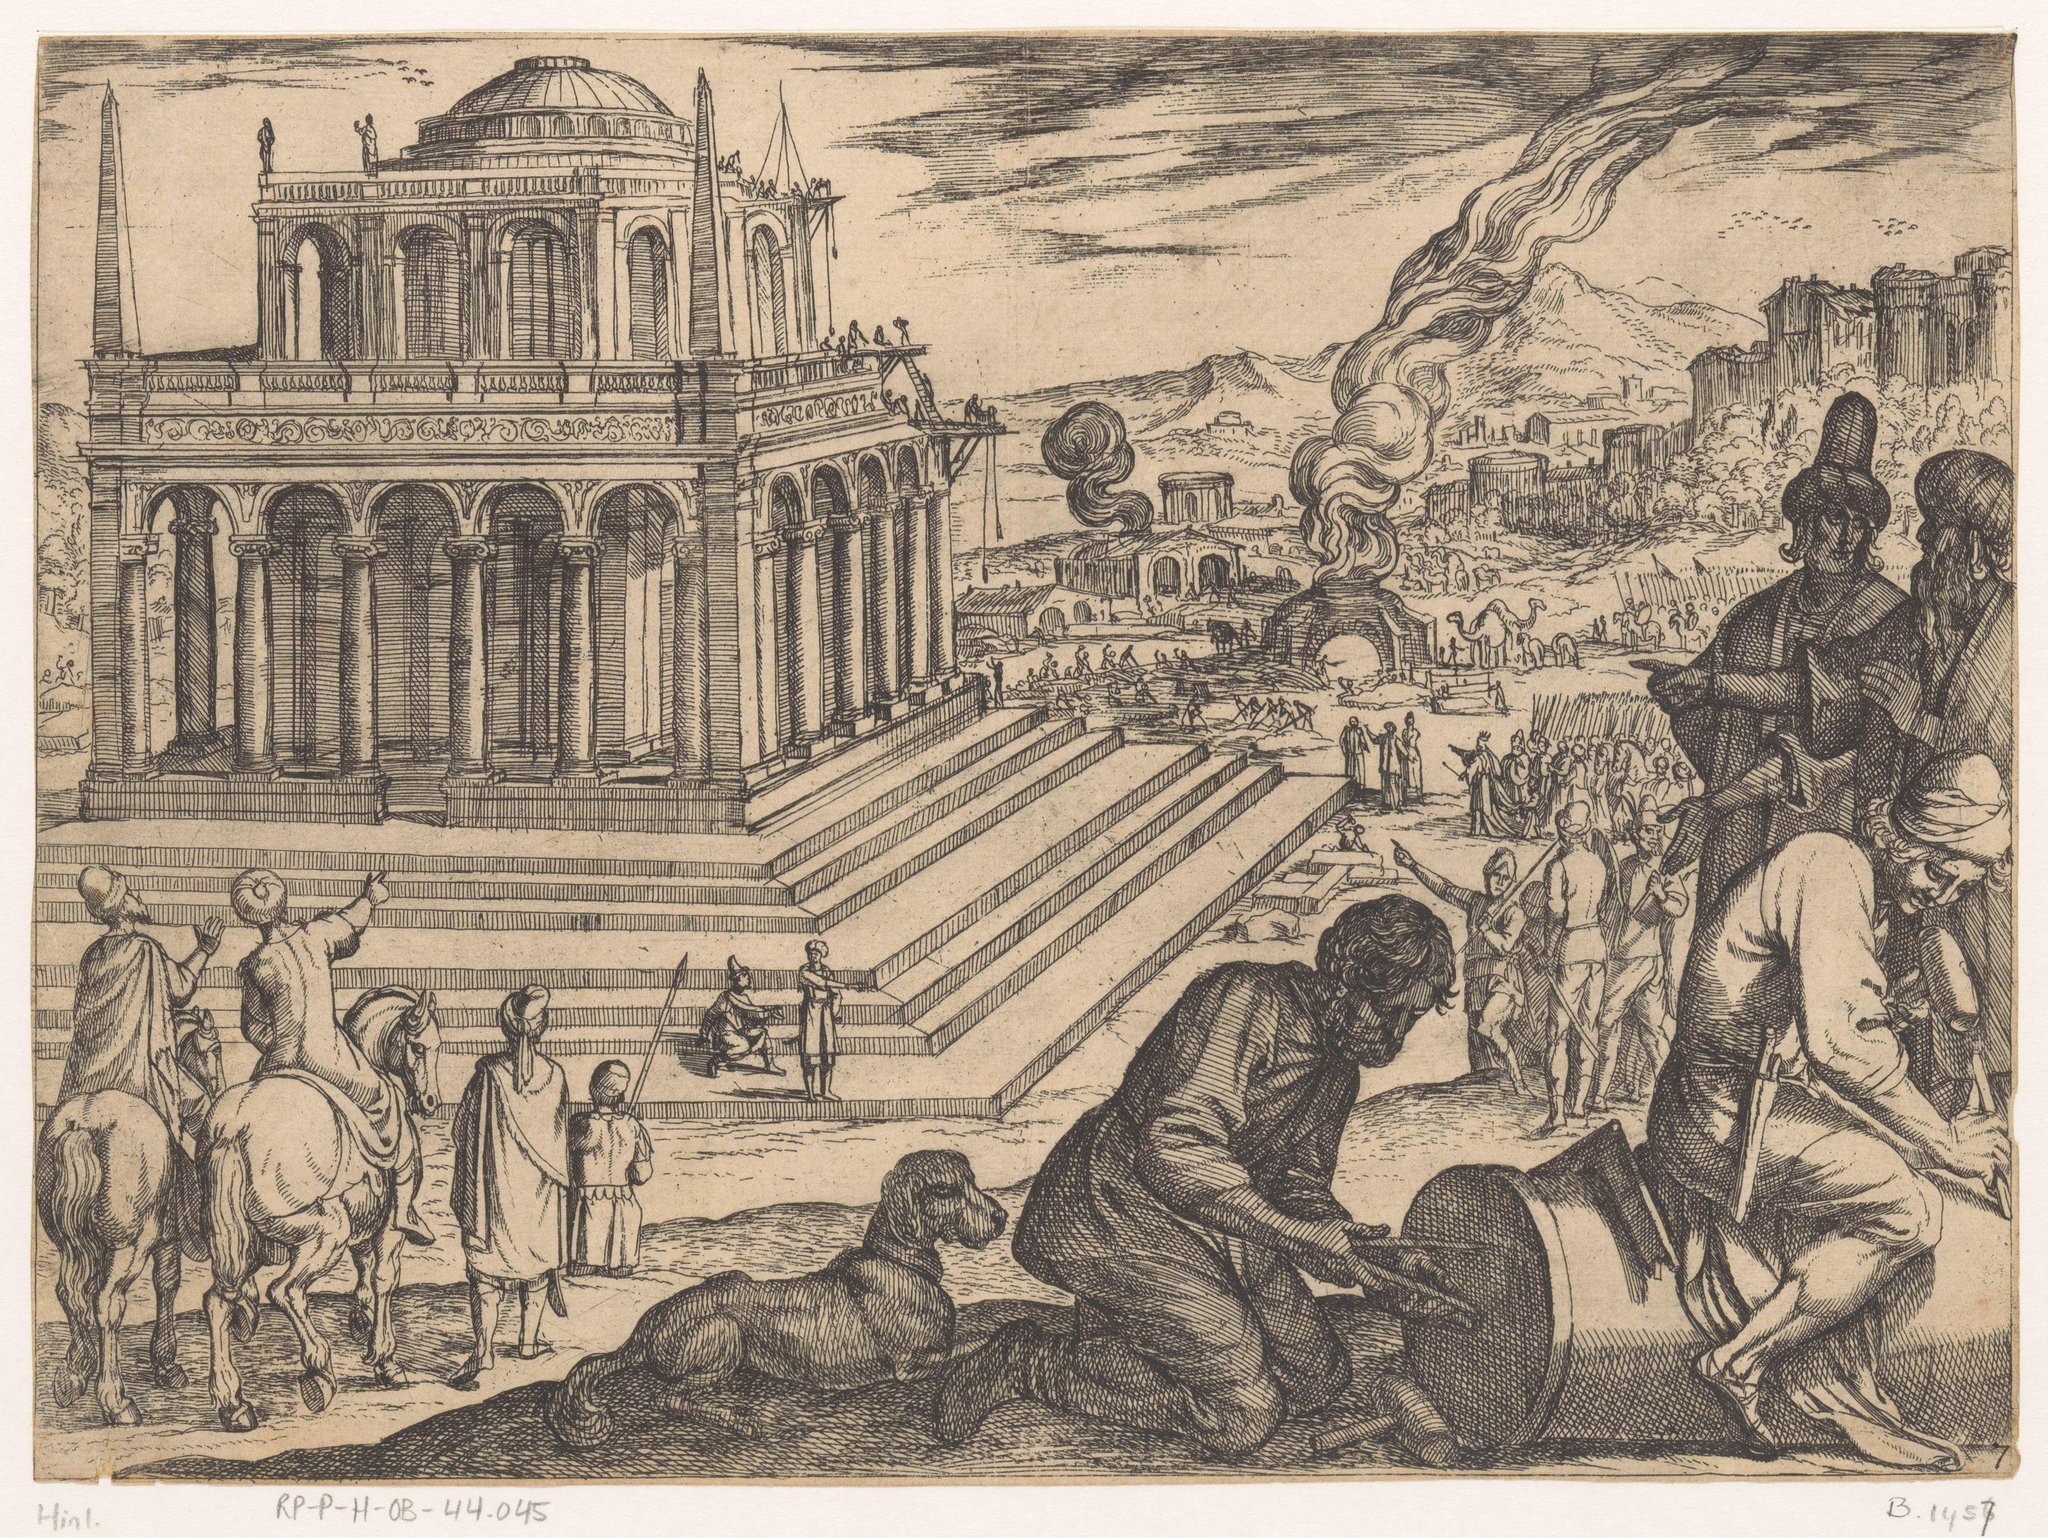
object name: print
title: De zeven wereldwonderen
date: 1608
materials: paper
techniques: etching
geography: antwerp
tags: the seven wonders of the world, mausoleum at halicarnassus (wonder of the world)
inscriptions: collector's mark: ‘Hinloopen’, collector's mark: Lugt 11, number: ‘7’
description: Het Mausoleum van Halicarnassus in aanbouw. De graftombe van koning Mausolus, een Perzische stadsvorst van Halicarnassus uit de 4e eeuw v. Chr. Het werd na zijn dood in 353 v. Chr. gebouwd in opdracht van zijn weduwe, koningin Artemisa.